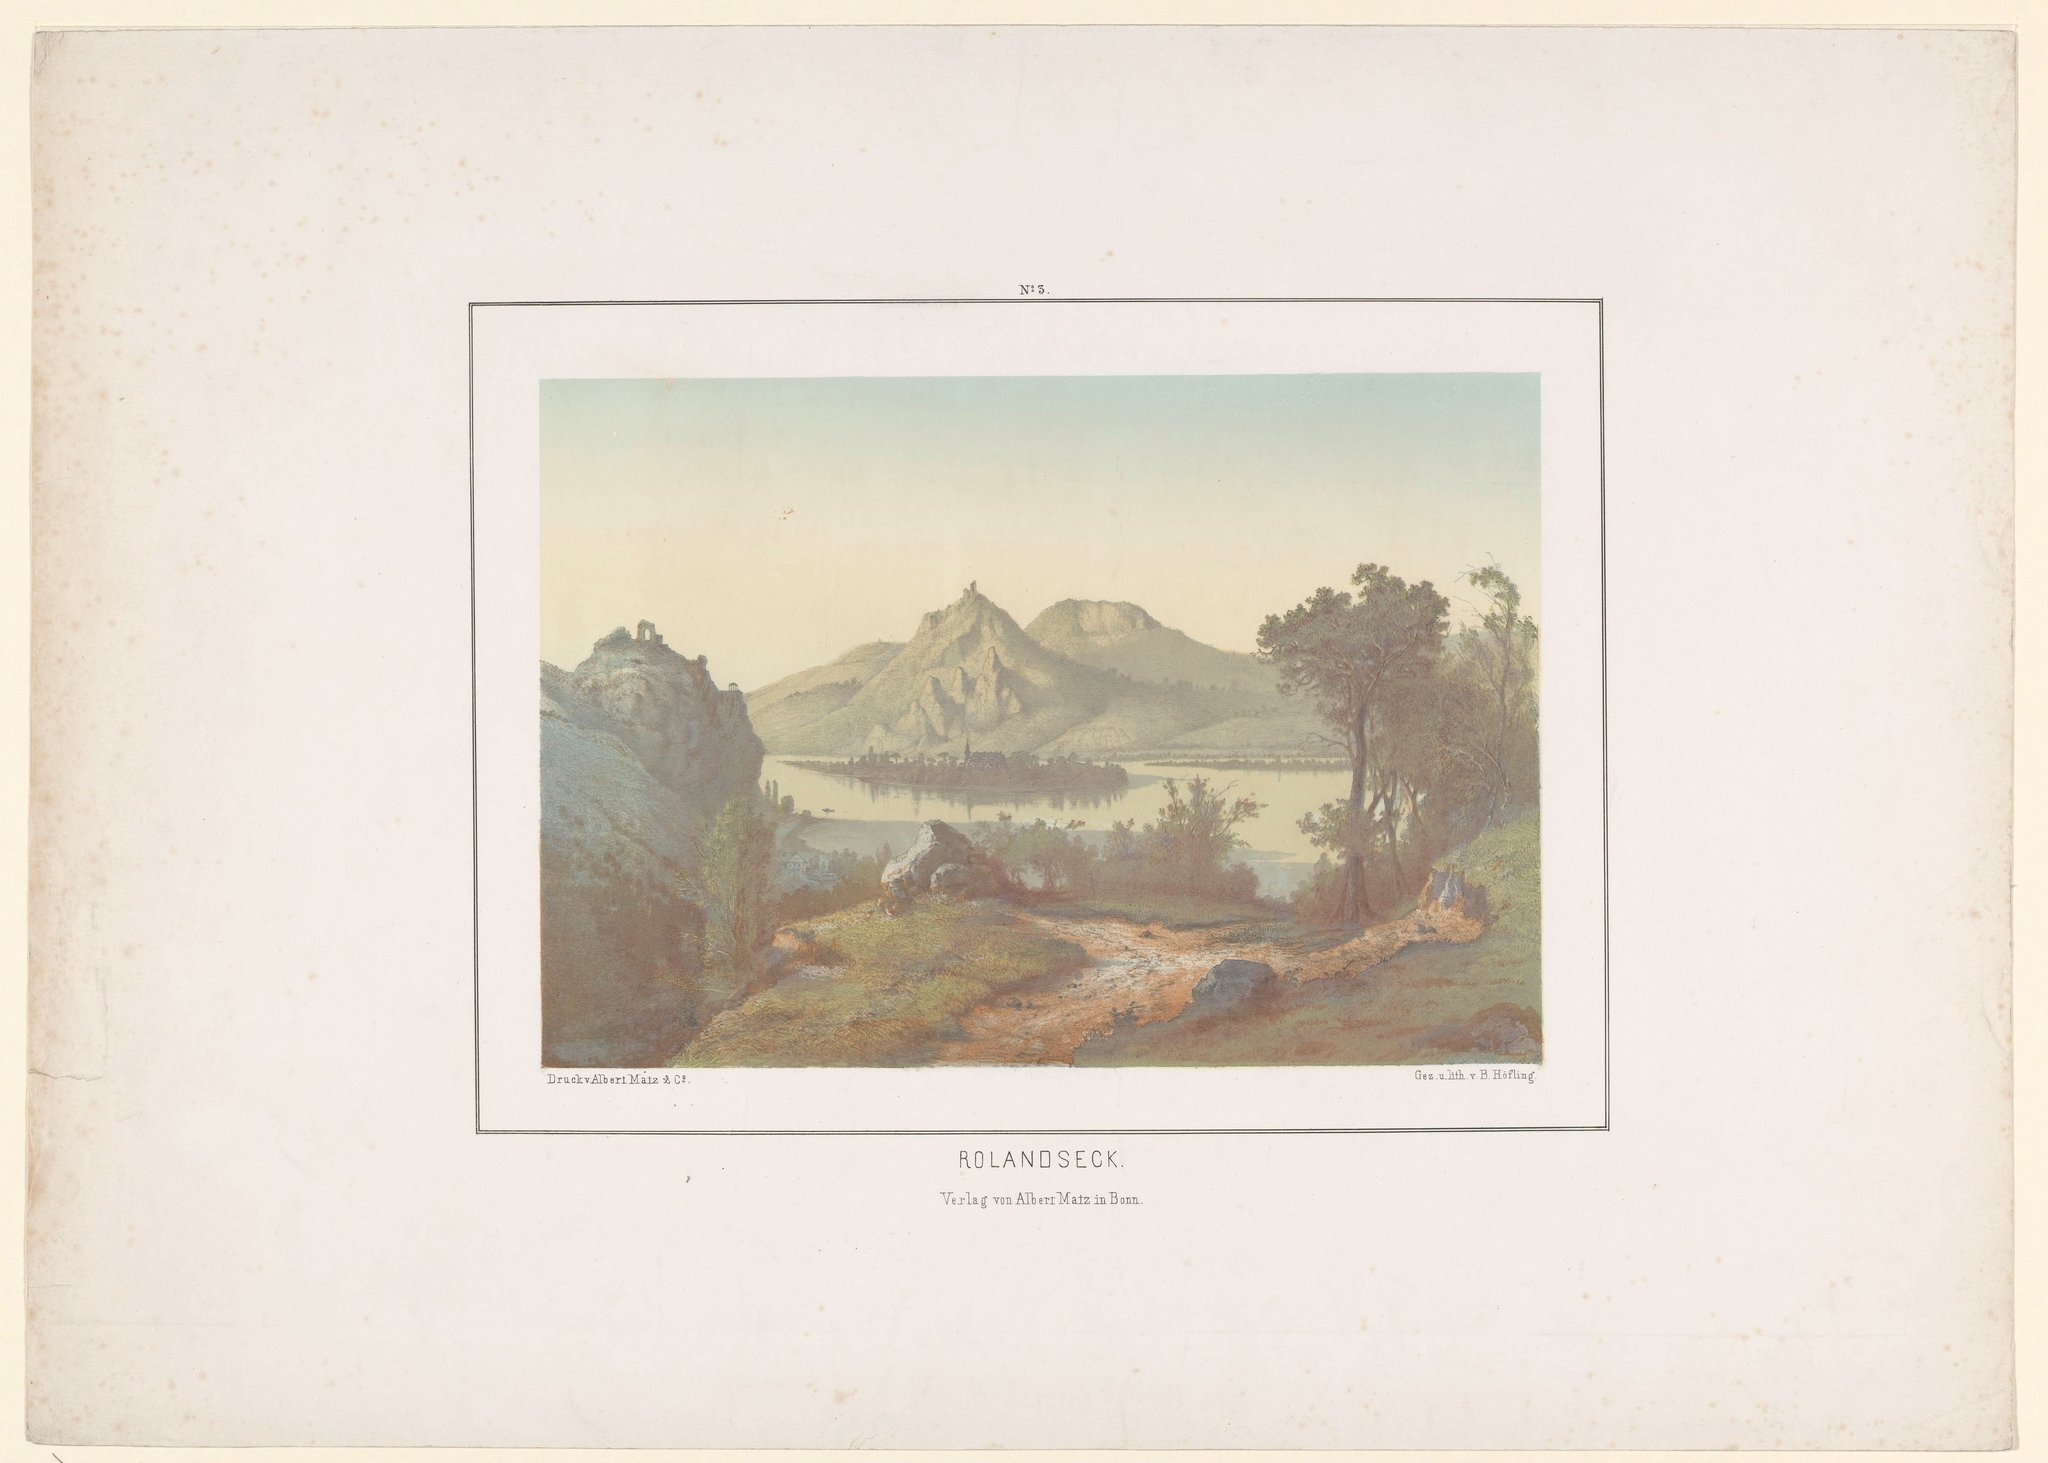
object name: print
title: Rolandseck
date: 1827-1871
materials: paper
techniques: lithograph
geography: bonn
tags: landscapes in the temperate zone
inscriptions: collector's mark: Lugt 2228